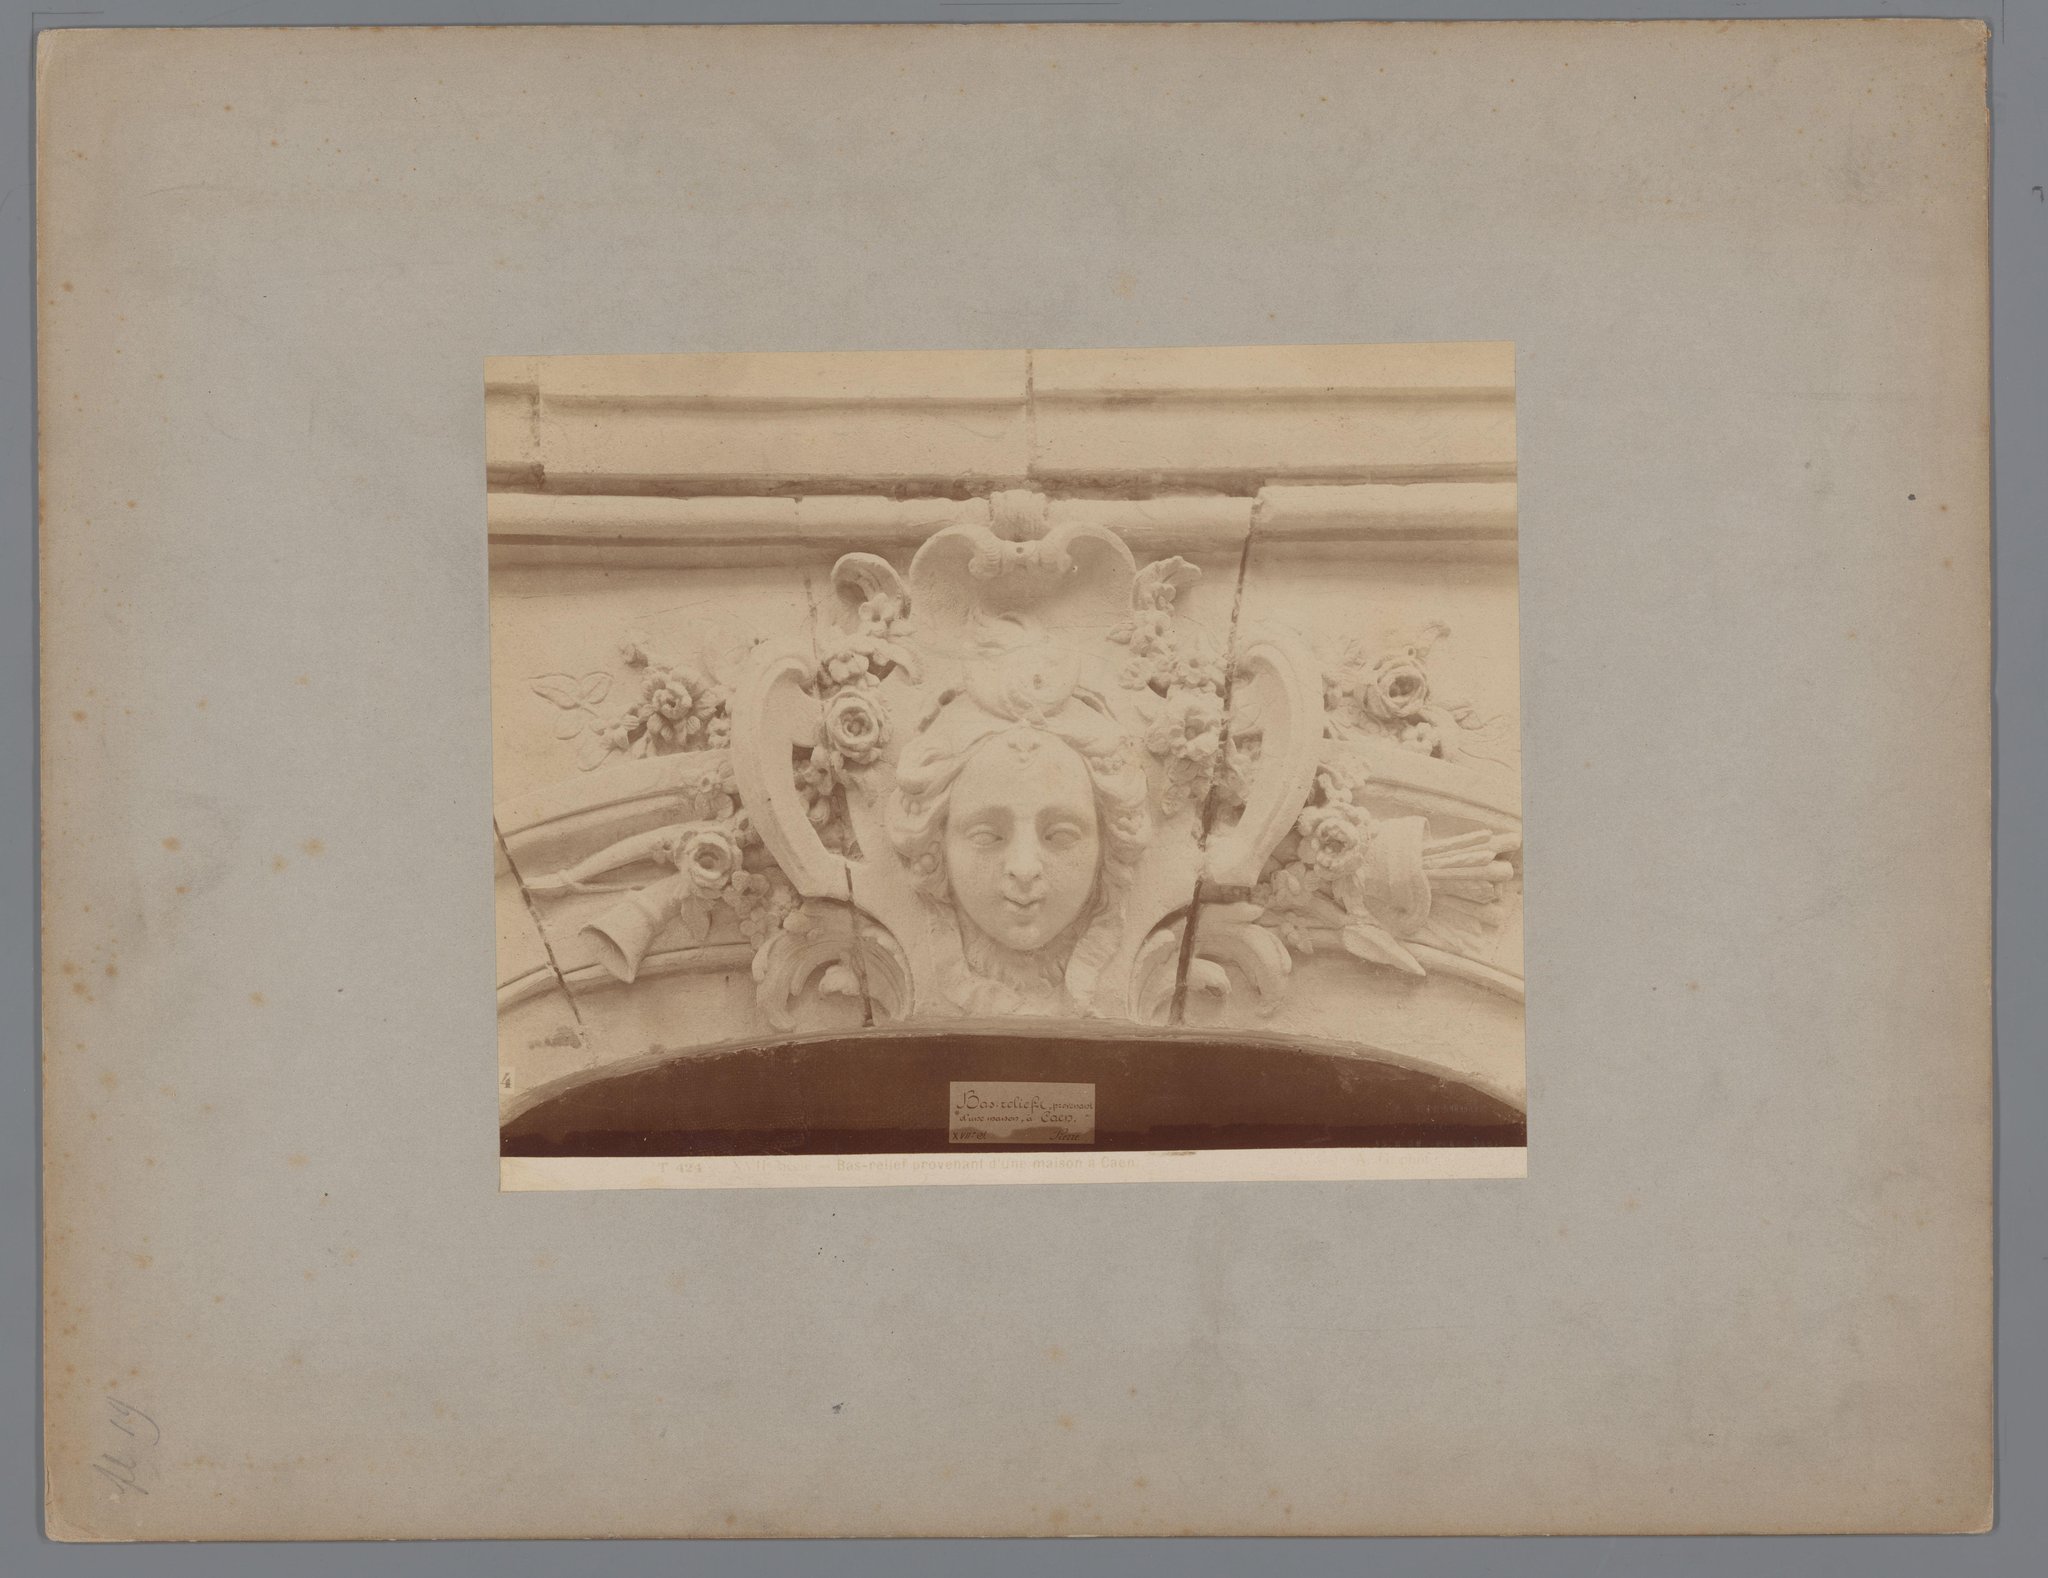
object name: photograph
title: Basreliëf met een vrouwengezicht, afkomstig van een huis in Caen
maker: adolphe giraudon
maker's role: publisher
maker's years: 1849-1929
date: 1875-1900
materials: cardboard, photographic support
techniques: albumen print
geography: paris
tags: mask, mascaron ~ ornament, flowers ~ ornament, sculpture (+ relief ~ sculpture)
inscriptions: collector's mark: Lugt 3937, inscription: ‘pl 19’, name: ‘A. GIRAUDON ÉDITEUR 15. R. BONAPARTE. PARIS’, number: ‘T 424’